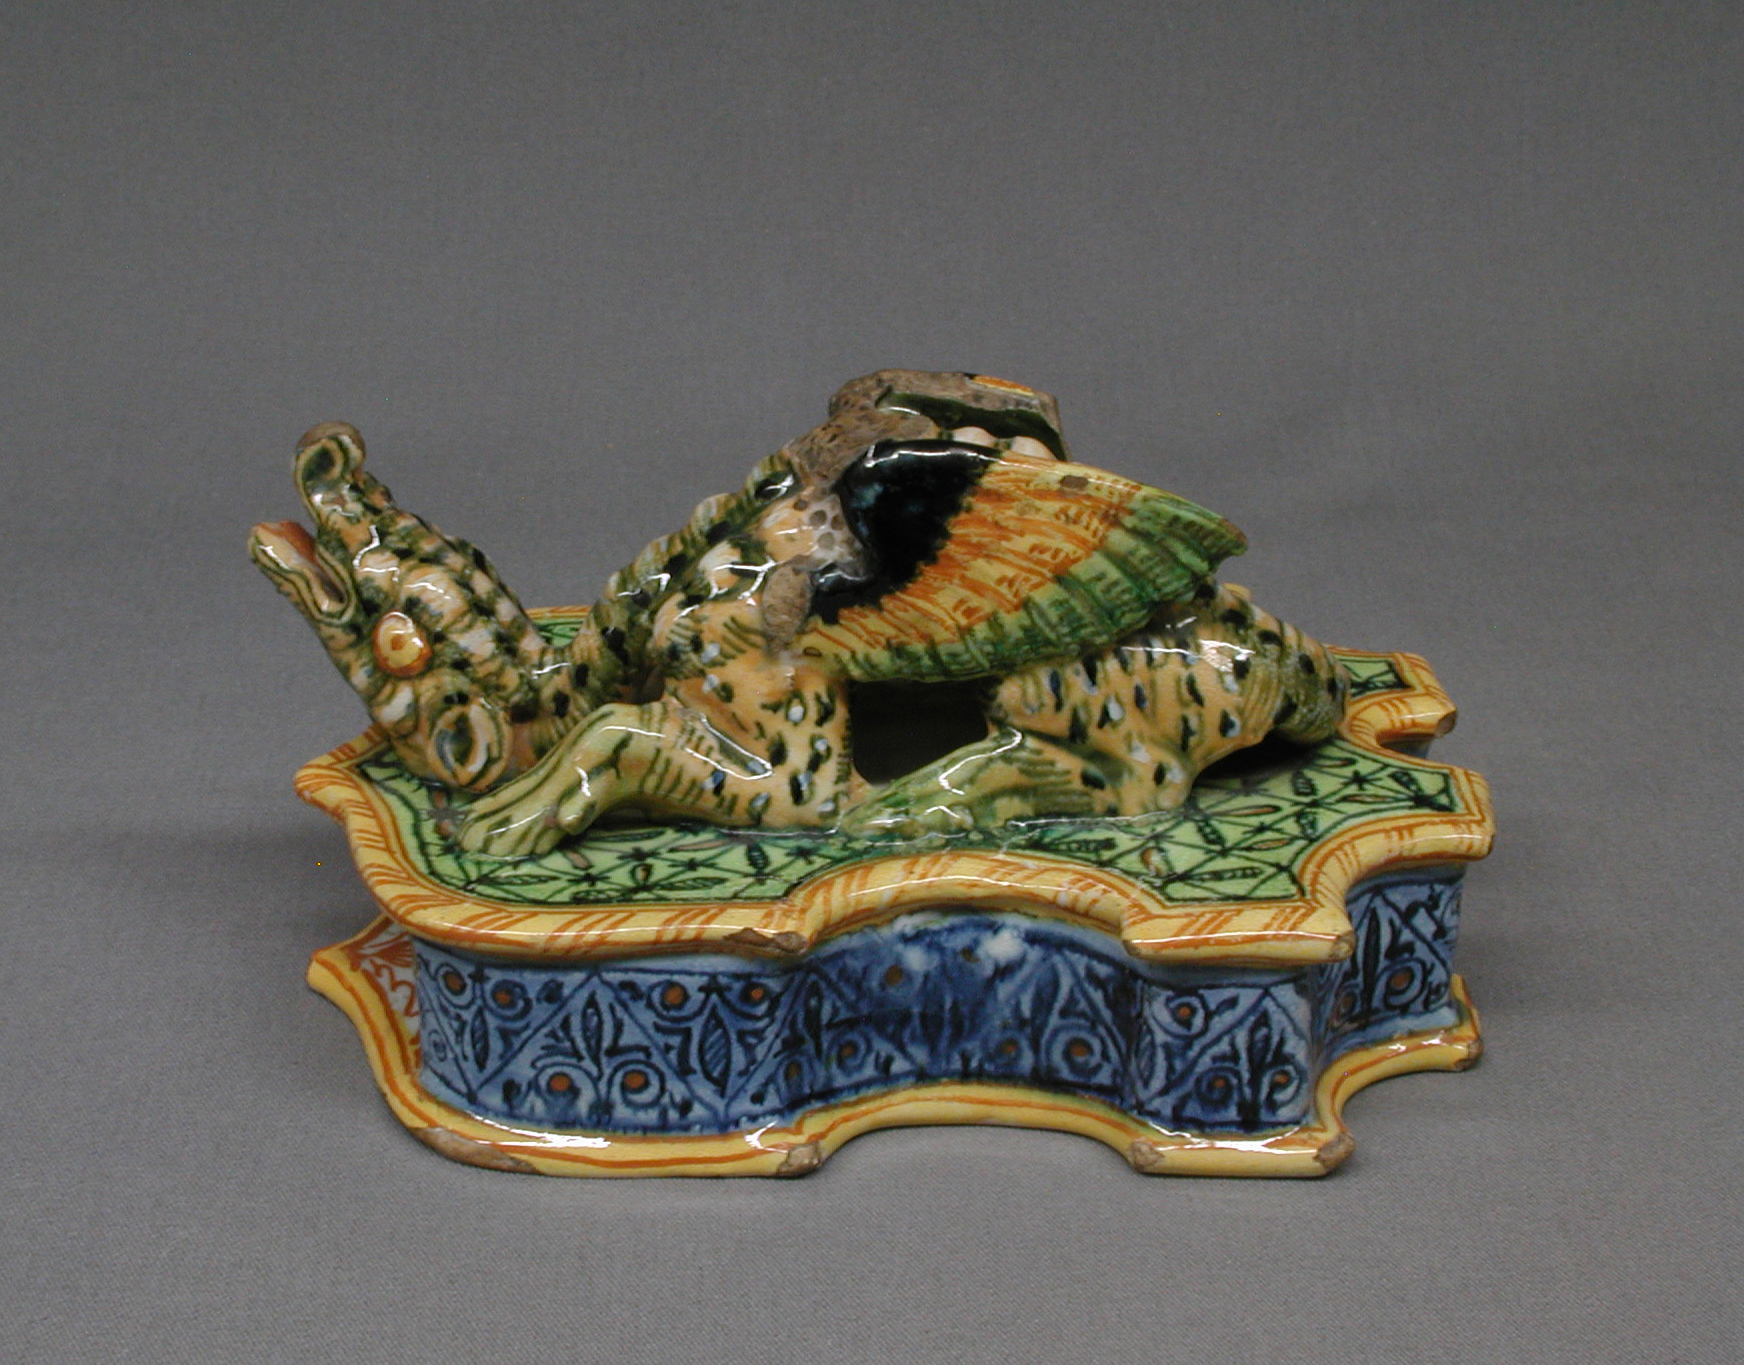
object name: inkstand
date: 1551-1600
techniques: maiolica, glazing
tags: dragons